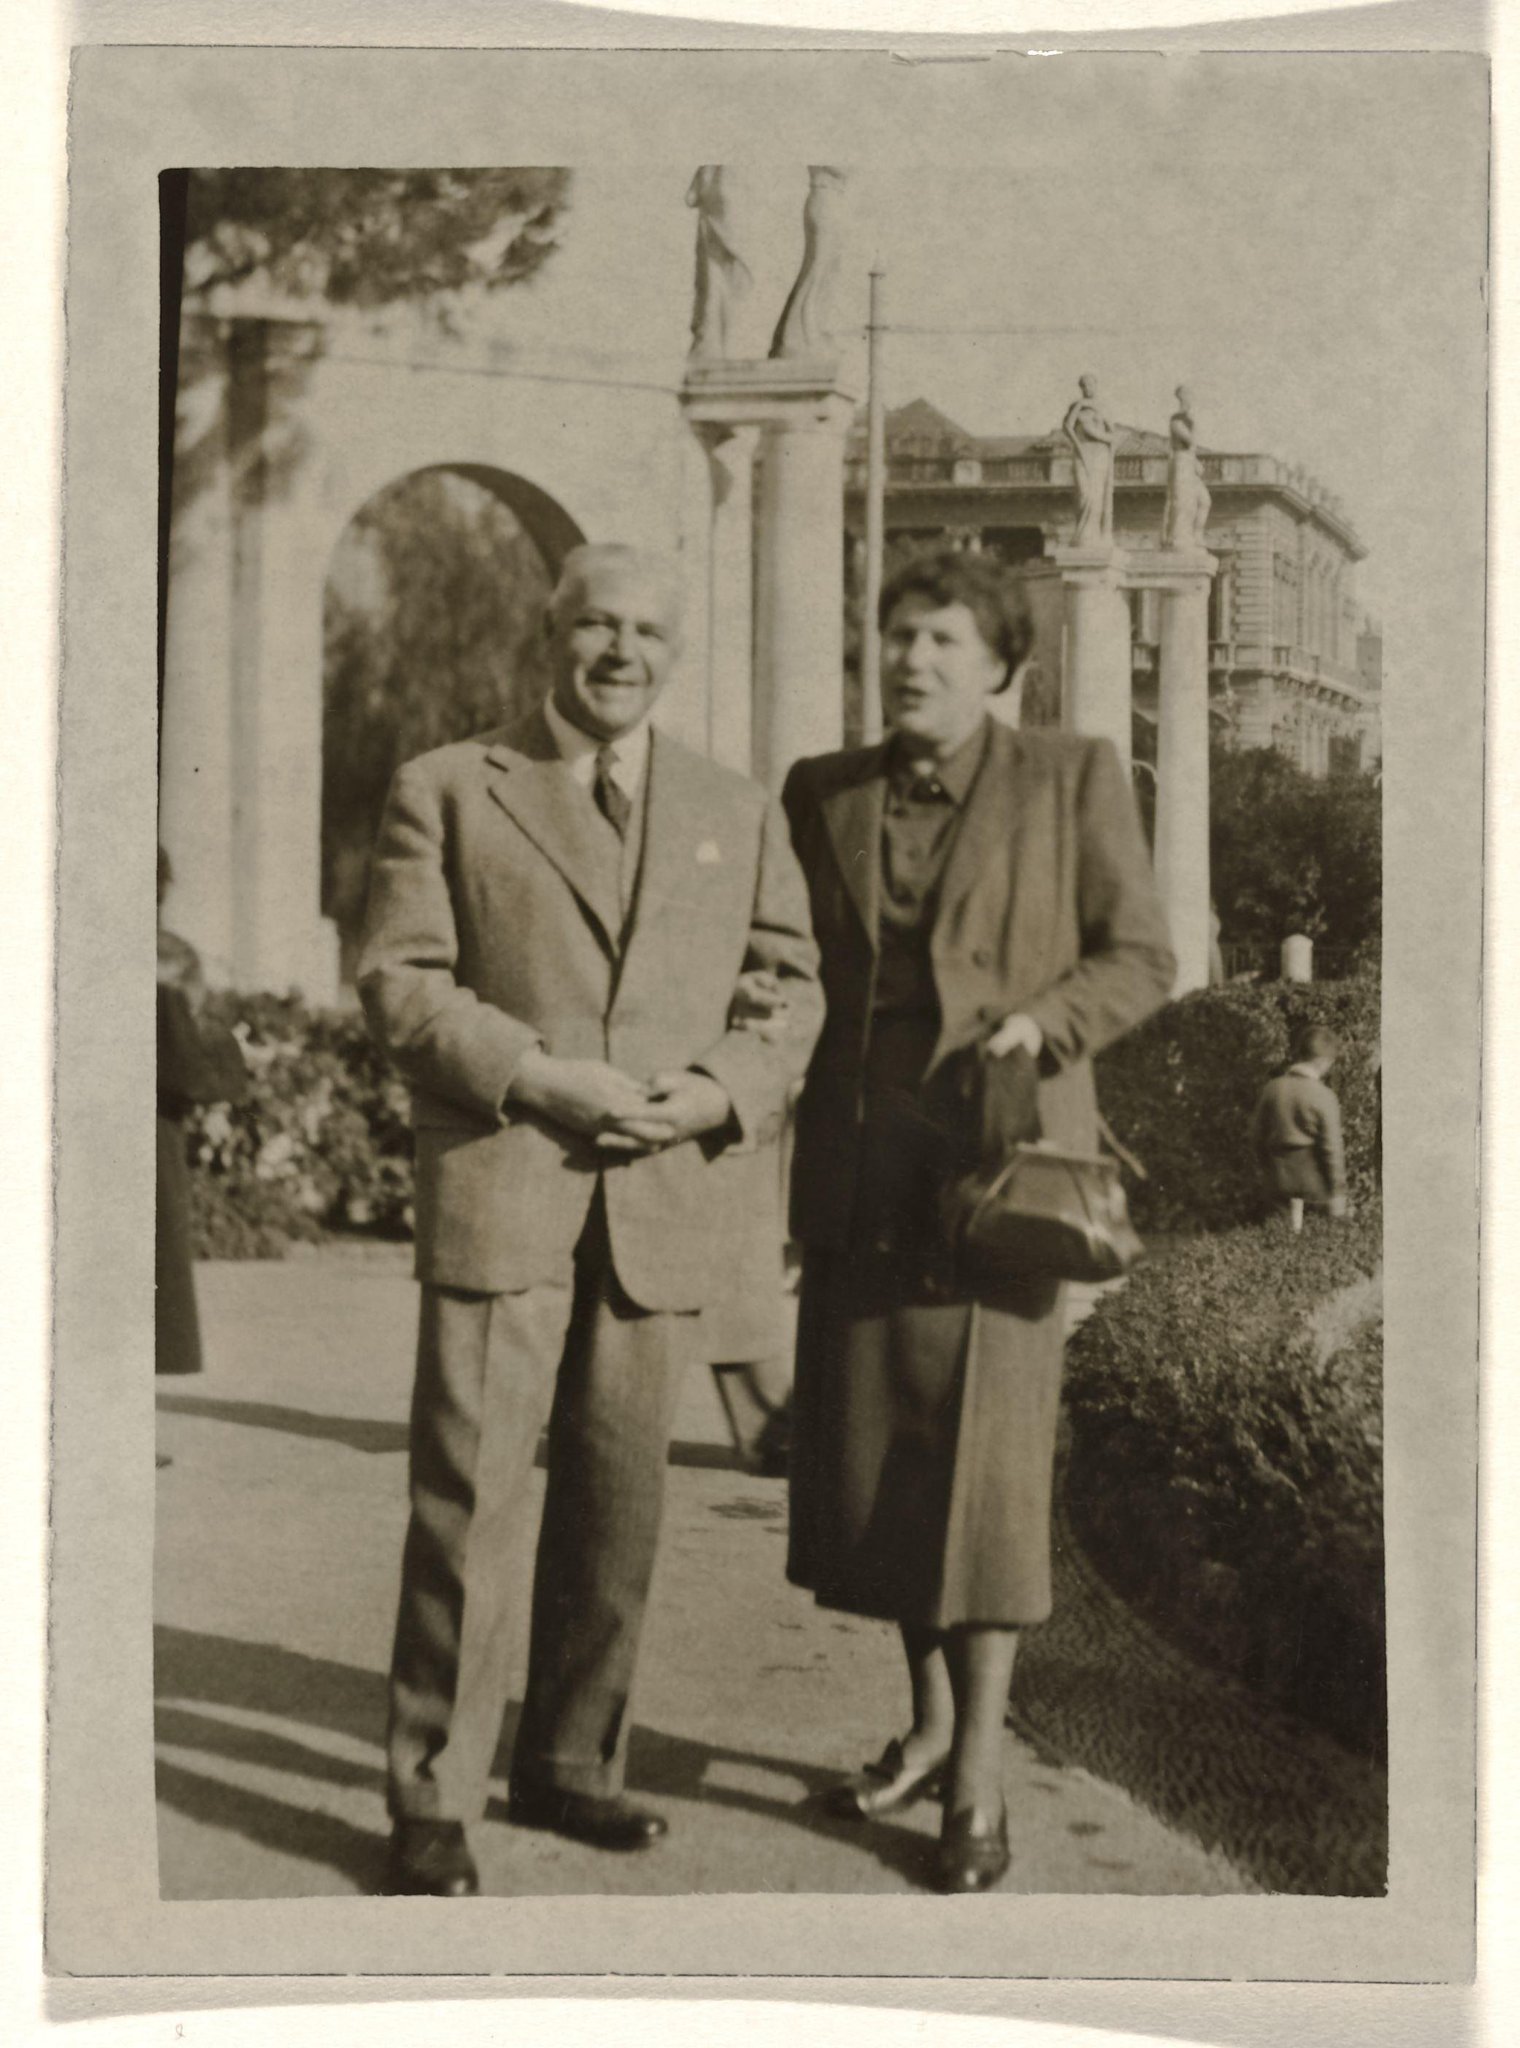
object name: photograph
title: Twee onbekende personen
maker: Anonymous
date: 1901-1950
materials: photographic support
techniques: gelatin silver print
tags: catanië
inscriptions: date: ‘aufgenommen Januar 1950 in Catania, Sicilia’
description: Twee onbekende personen, met op de achtergrond een boogpoort, standbeelden op de boogpoorten en struiken